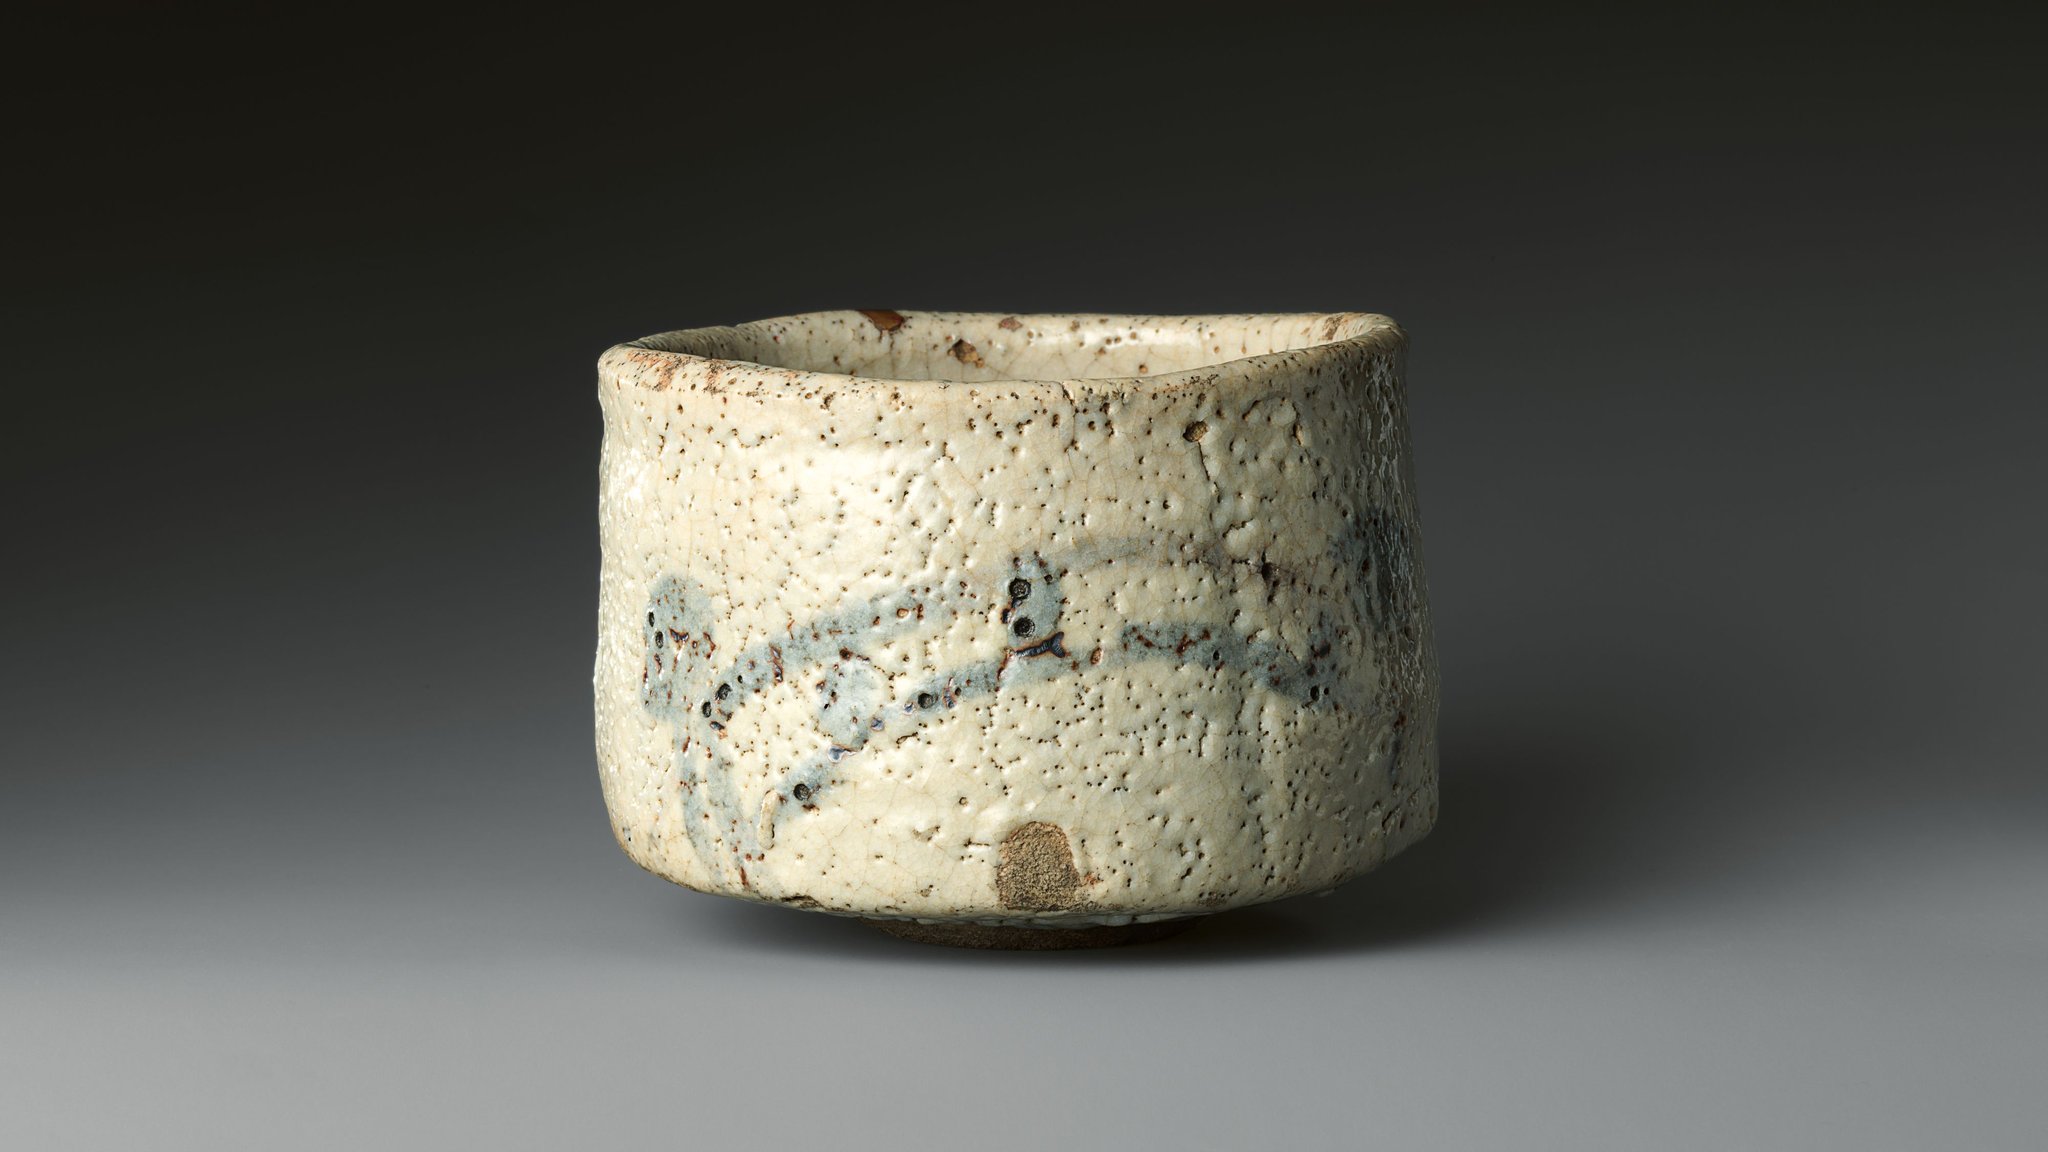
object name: teabowl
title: Shino Teabowl with Bridge and House, known as “Bridge of the Gods” (Shinkyō)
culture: japanese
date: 1567-1600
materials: iron, stoneware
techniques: glazing, painting